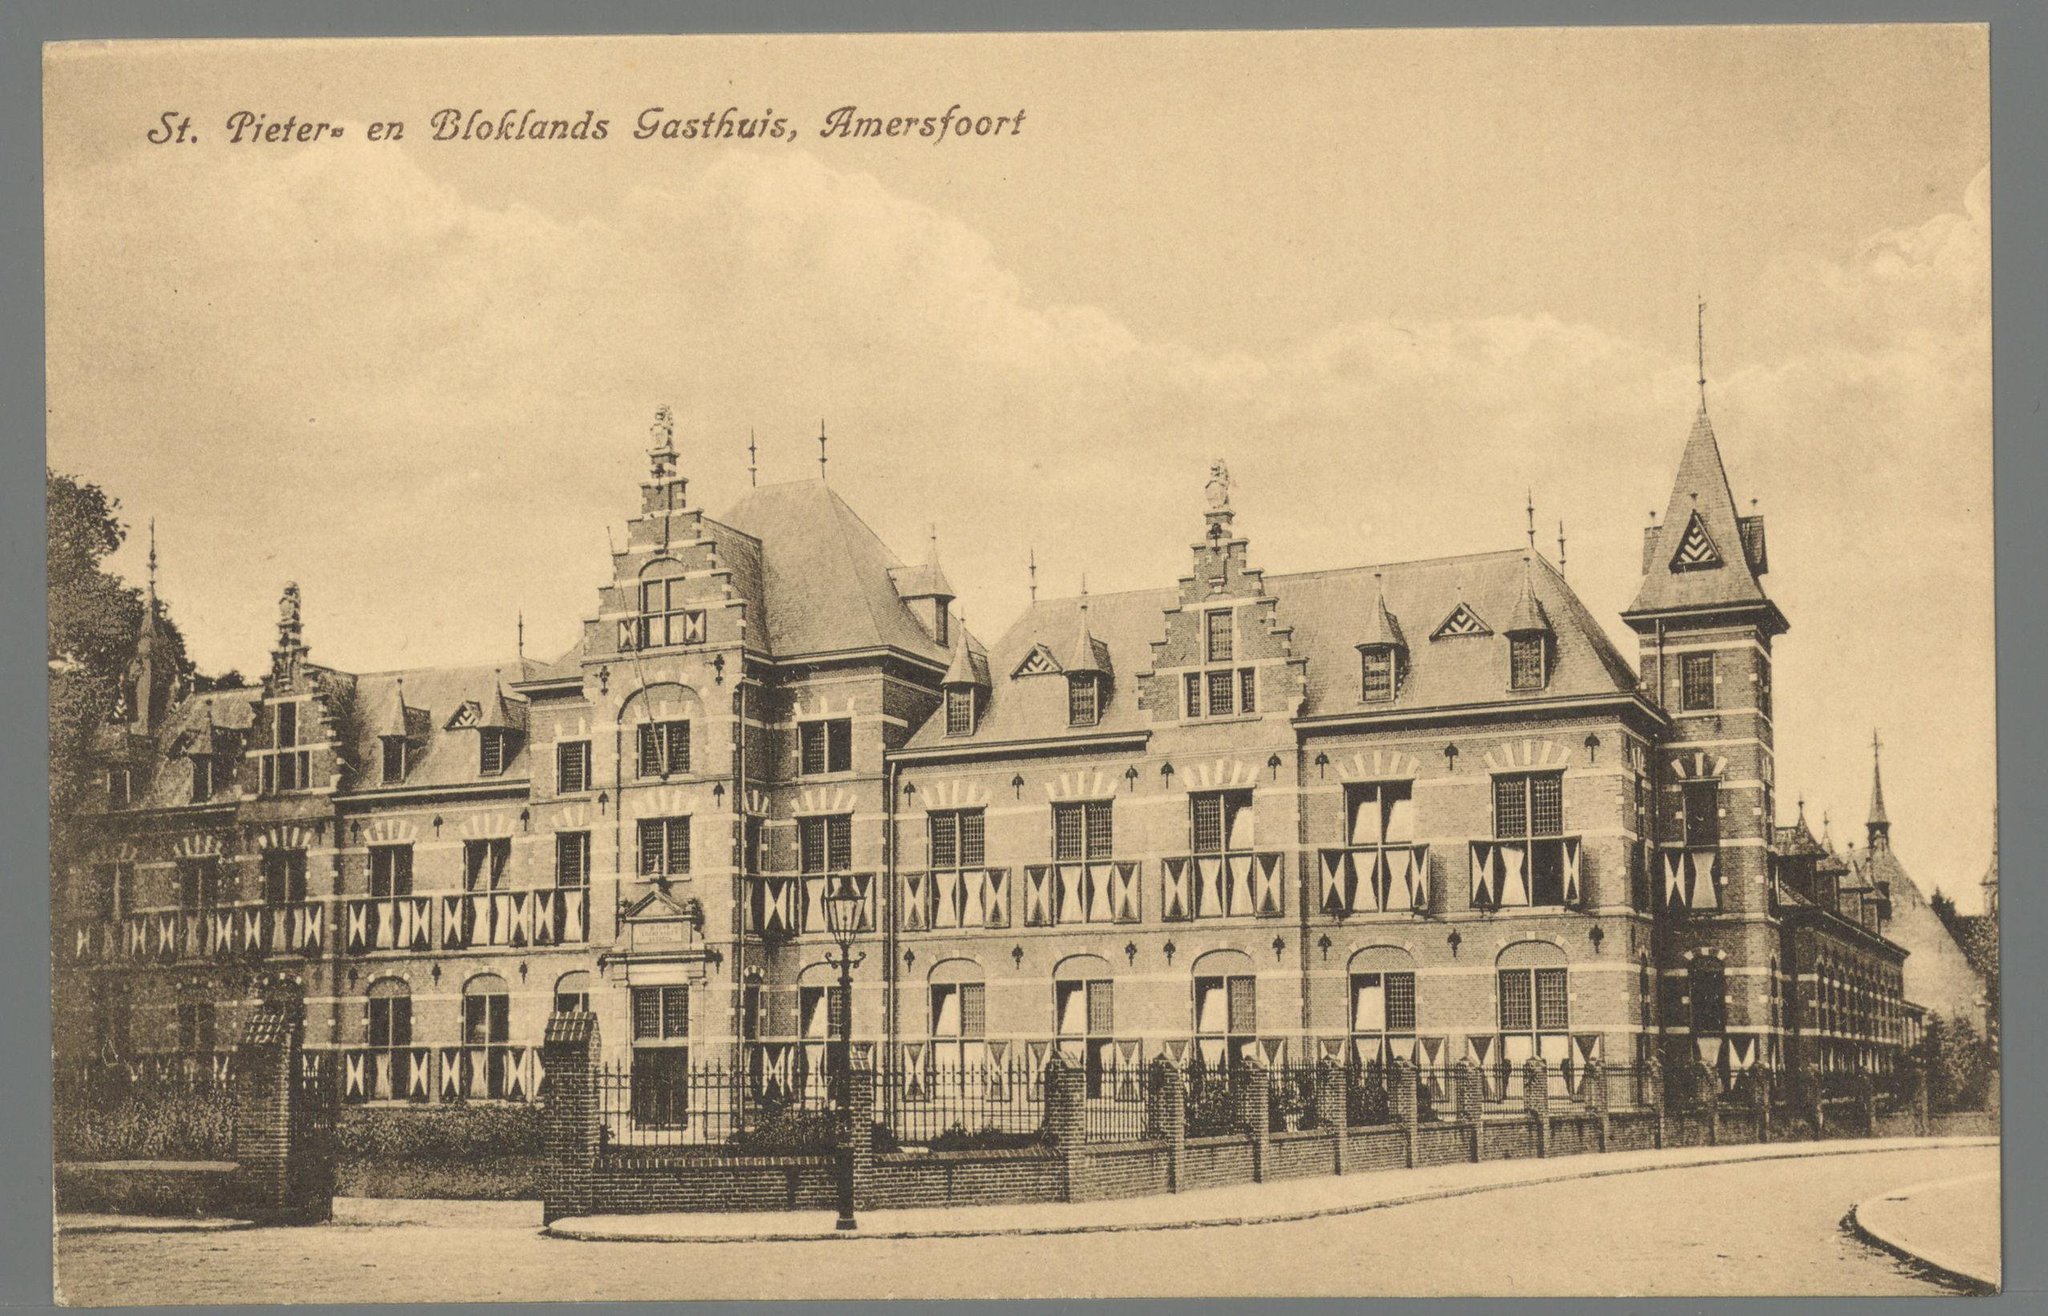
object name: ansichtkaart, prentbriefkaart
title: St. Pieter- en Bloklands Gasthuis, Amersfoort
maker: Anonymous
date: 1905-1930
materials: cardboard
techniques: photograph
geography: amersfoort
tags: old-people's home